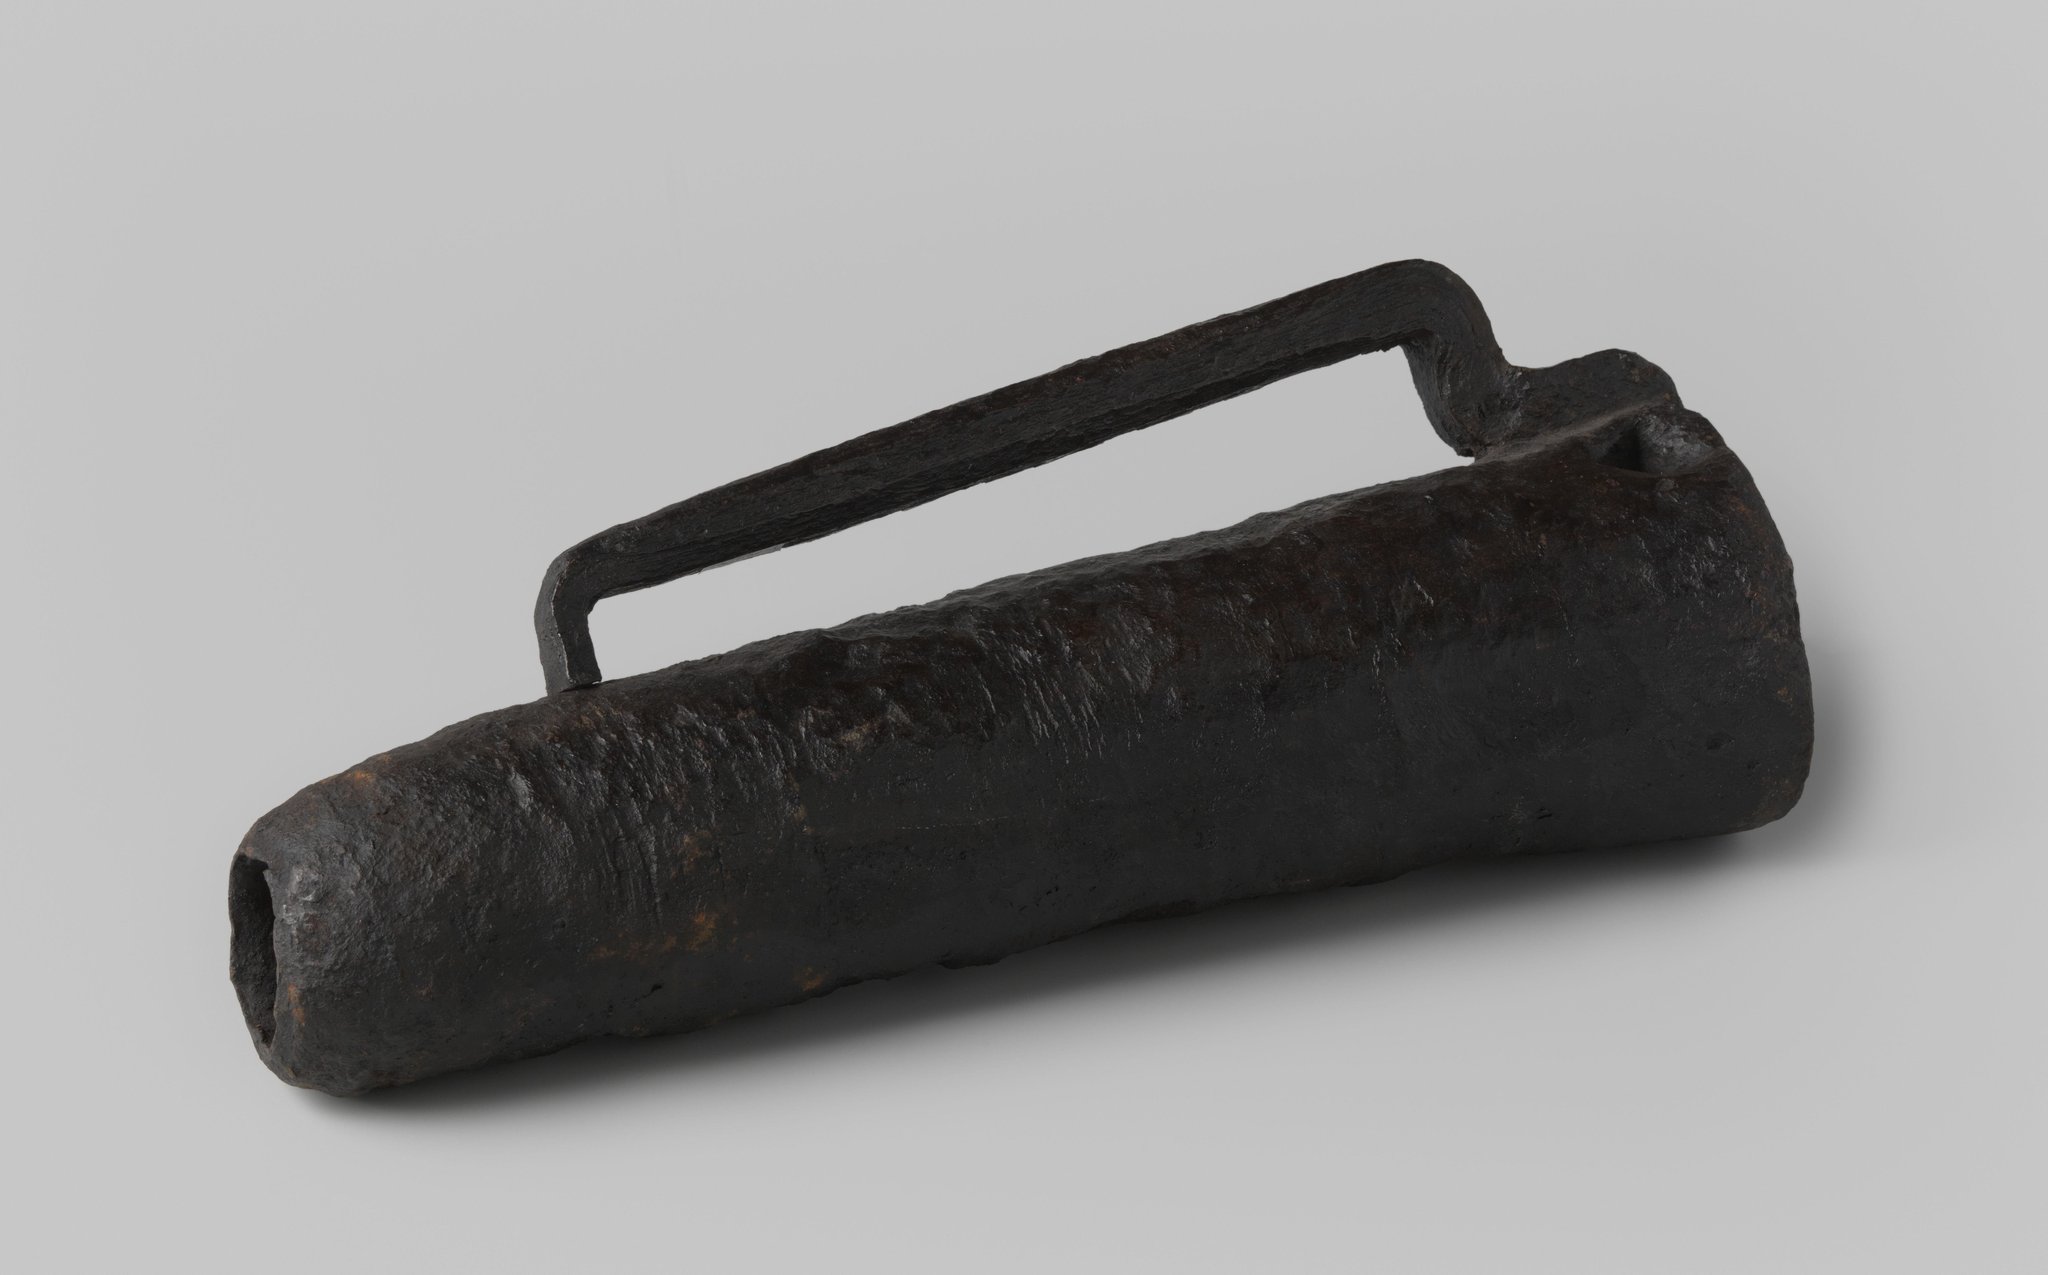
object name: cylinder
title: Losse kamer voor draaibas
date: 1500-1700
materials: bronze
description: Smeedijzeren achterlaadkanon op draaibare houten bedding. Nederland, ca. 1570. Dit kanon werd gevonden in de Haarlemmermeer - waar nu de luchthaven Schiphol is - en is vermoedelijk afkomstig van de slag op de Haarlemmermeer in 1573.